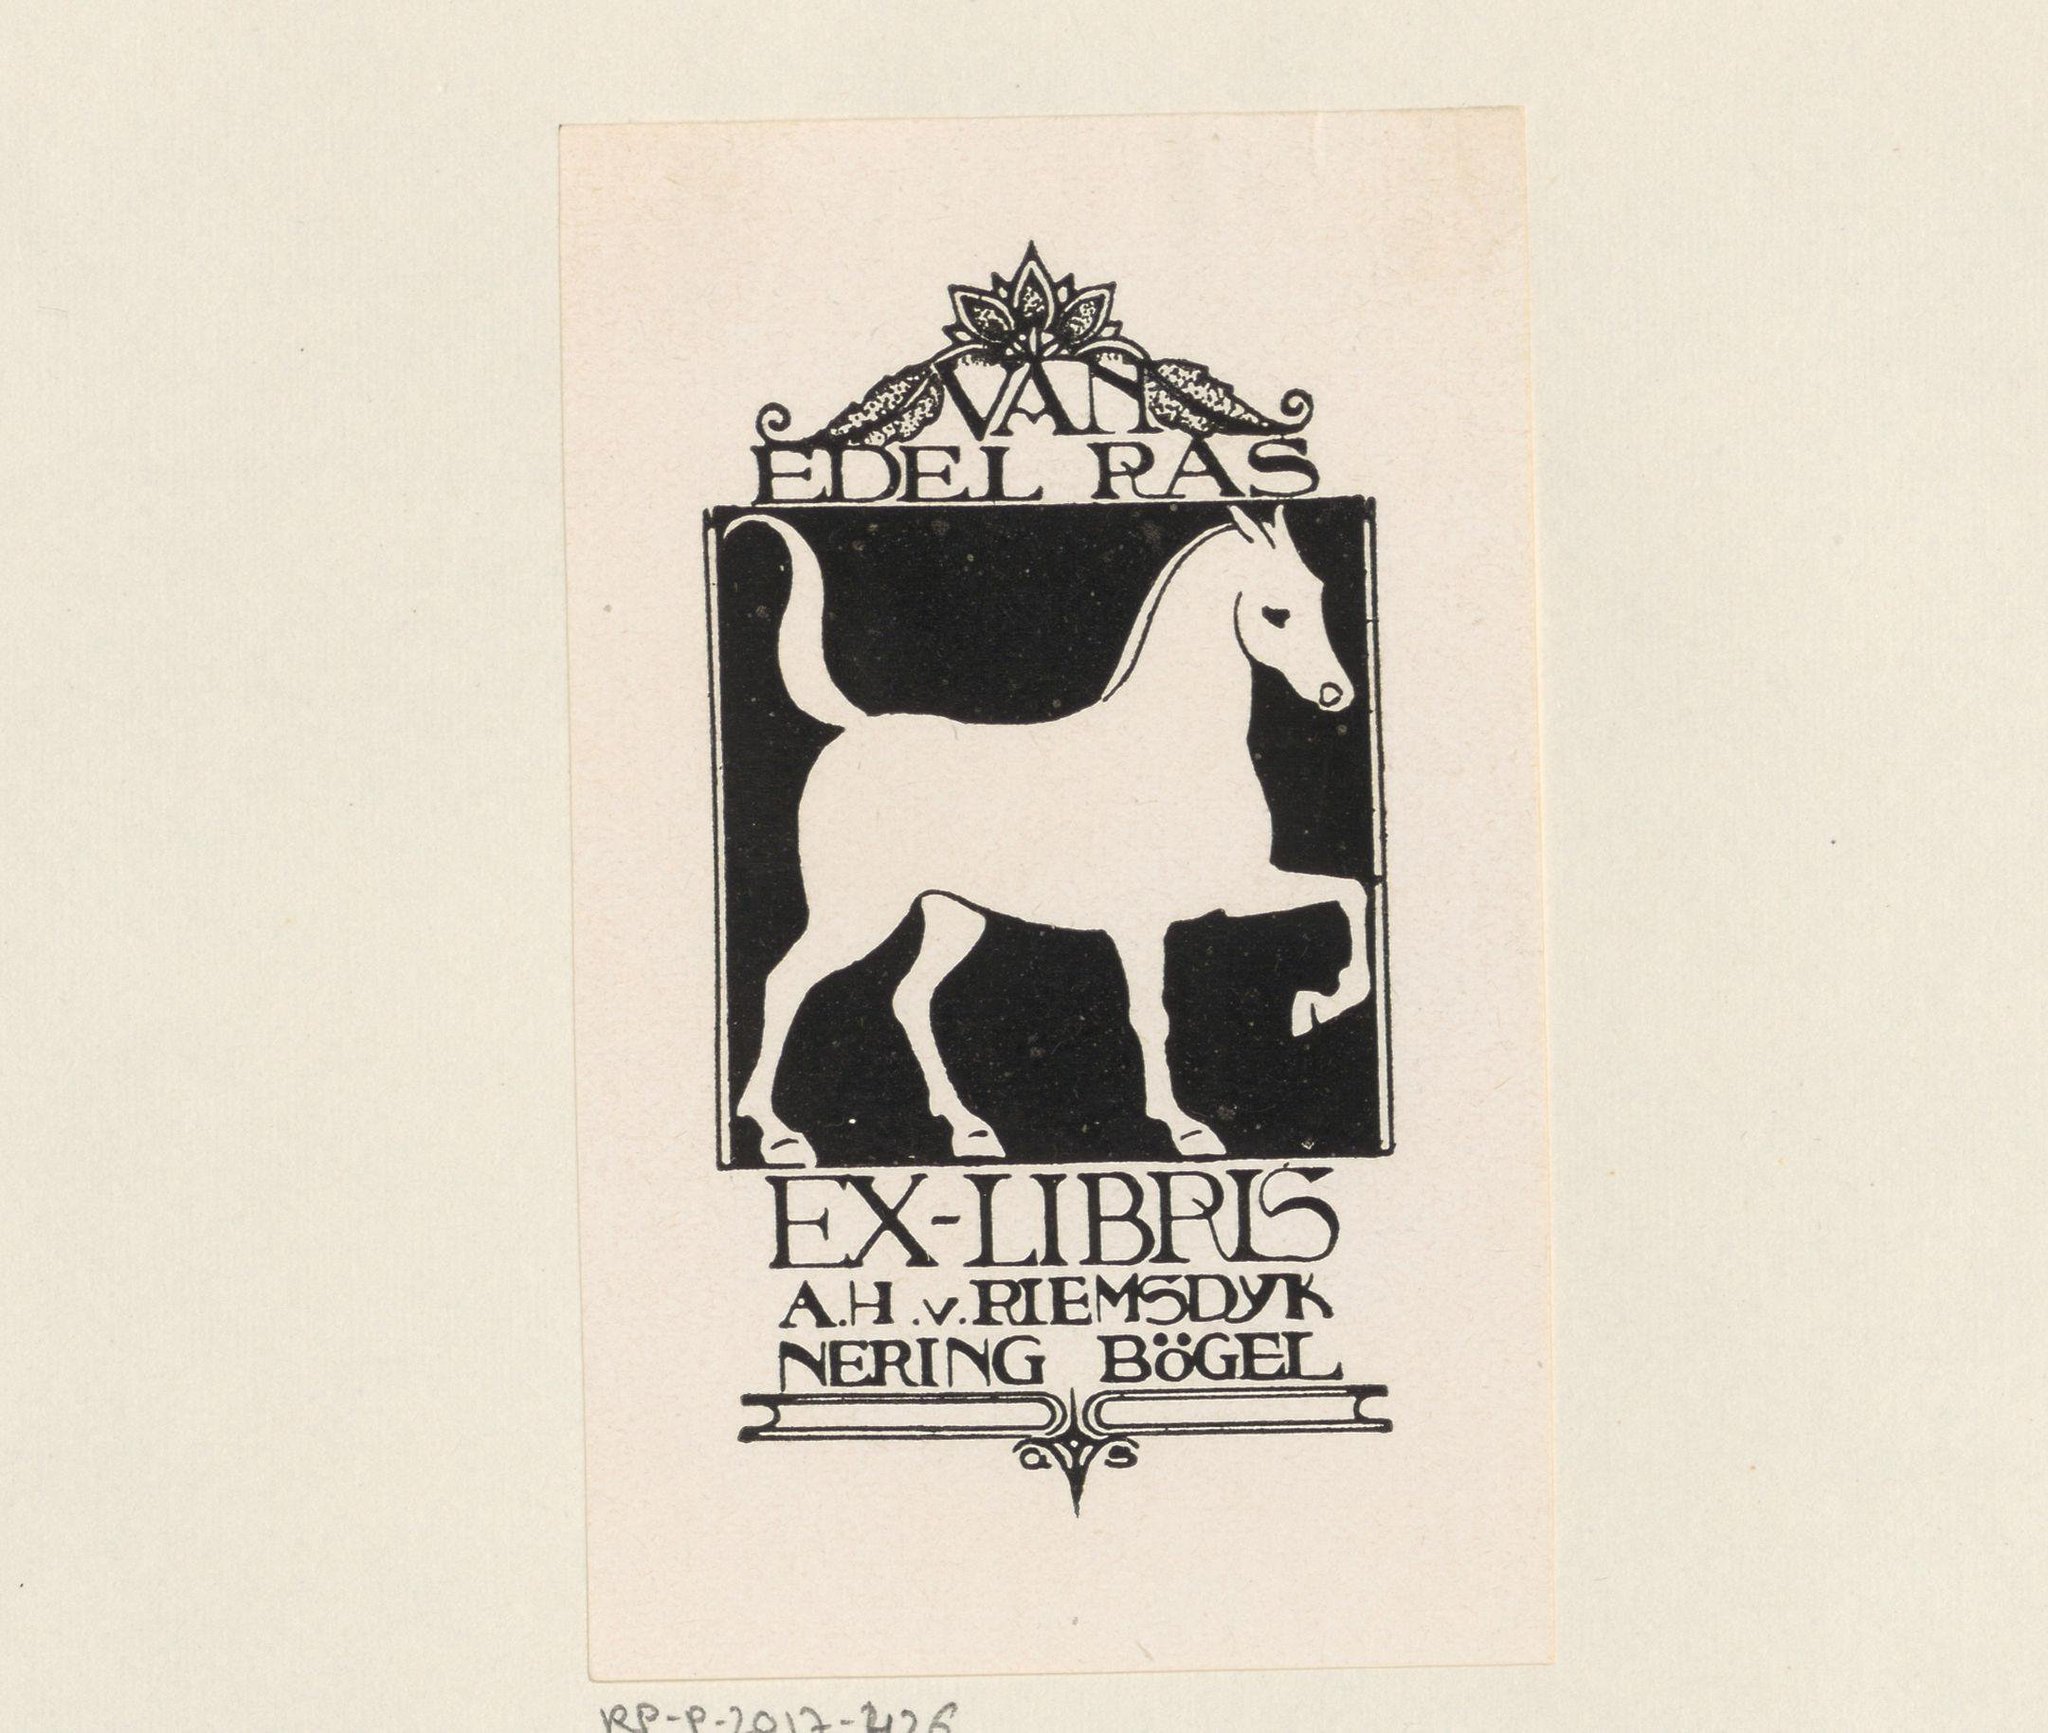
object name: bookplate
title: Ex libris van A.H. van Riemsdijk-Nering Bögel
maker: Anonymous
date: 1900-1999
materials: paper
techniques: printing block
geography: netherlands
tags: horse